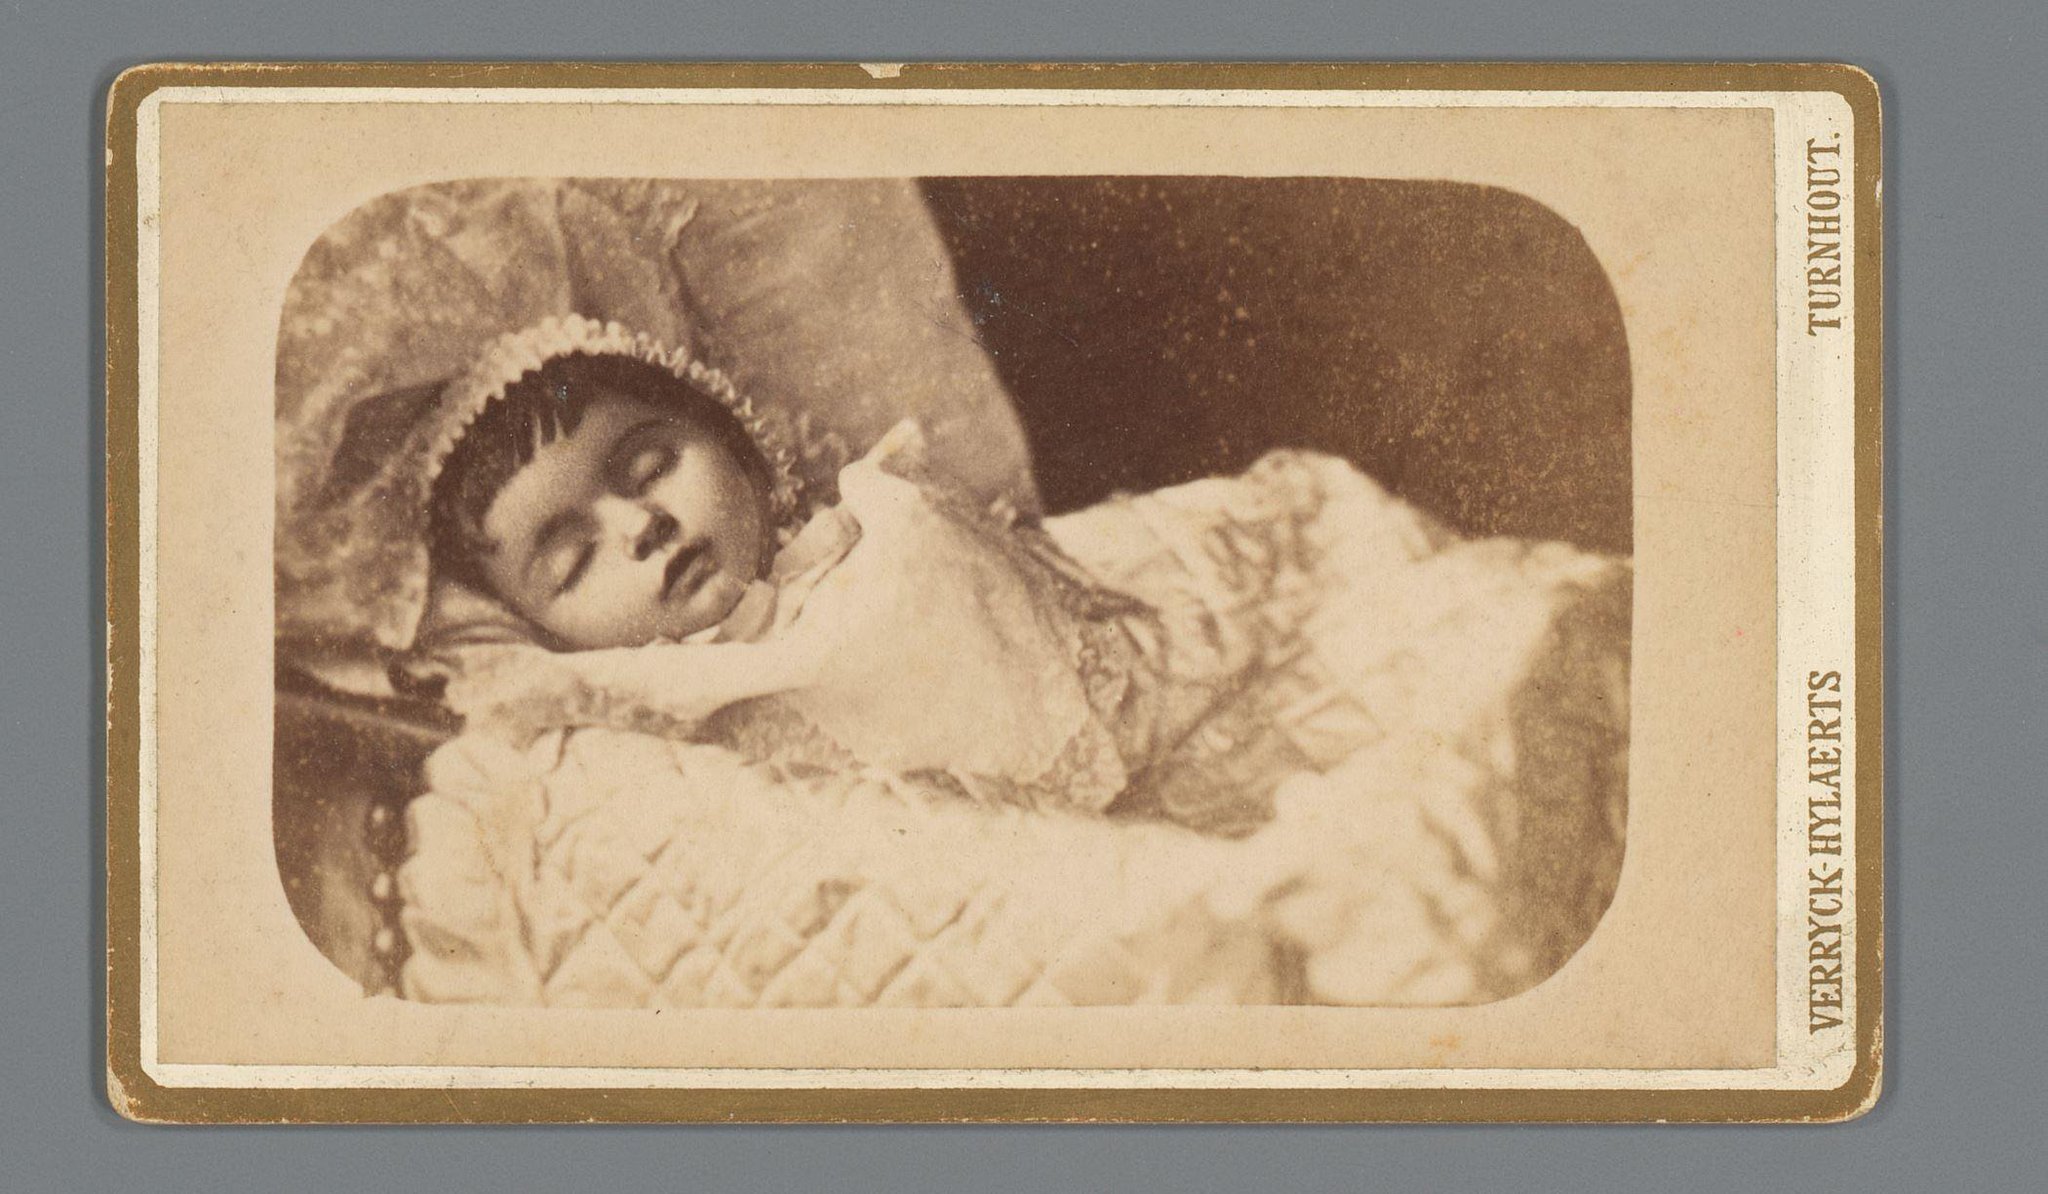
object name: carte de visite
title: Post-mortemportret van een onbekend kind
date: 1865-1897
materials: cardboard, paper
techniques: albumen print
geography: turnhout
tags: child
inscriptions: inscription: ‘Bondy & C. Wien/ Men kan van deze portretten nabestellen.’